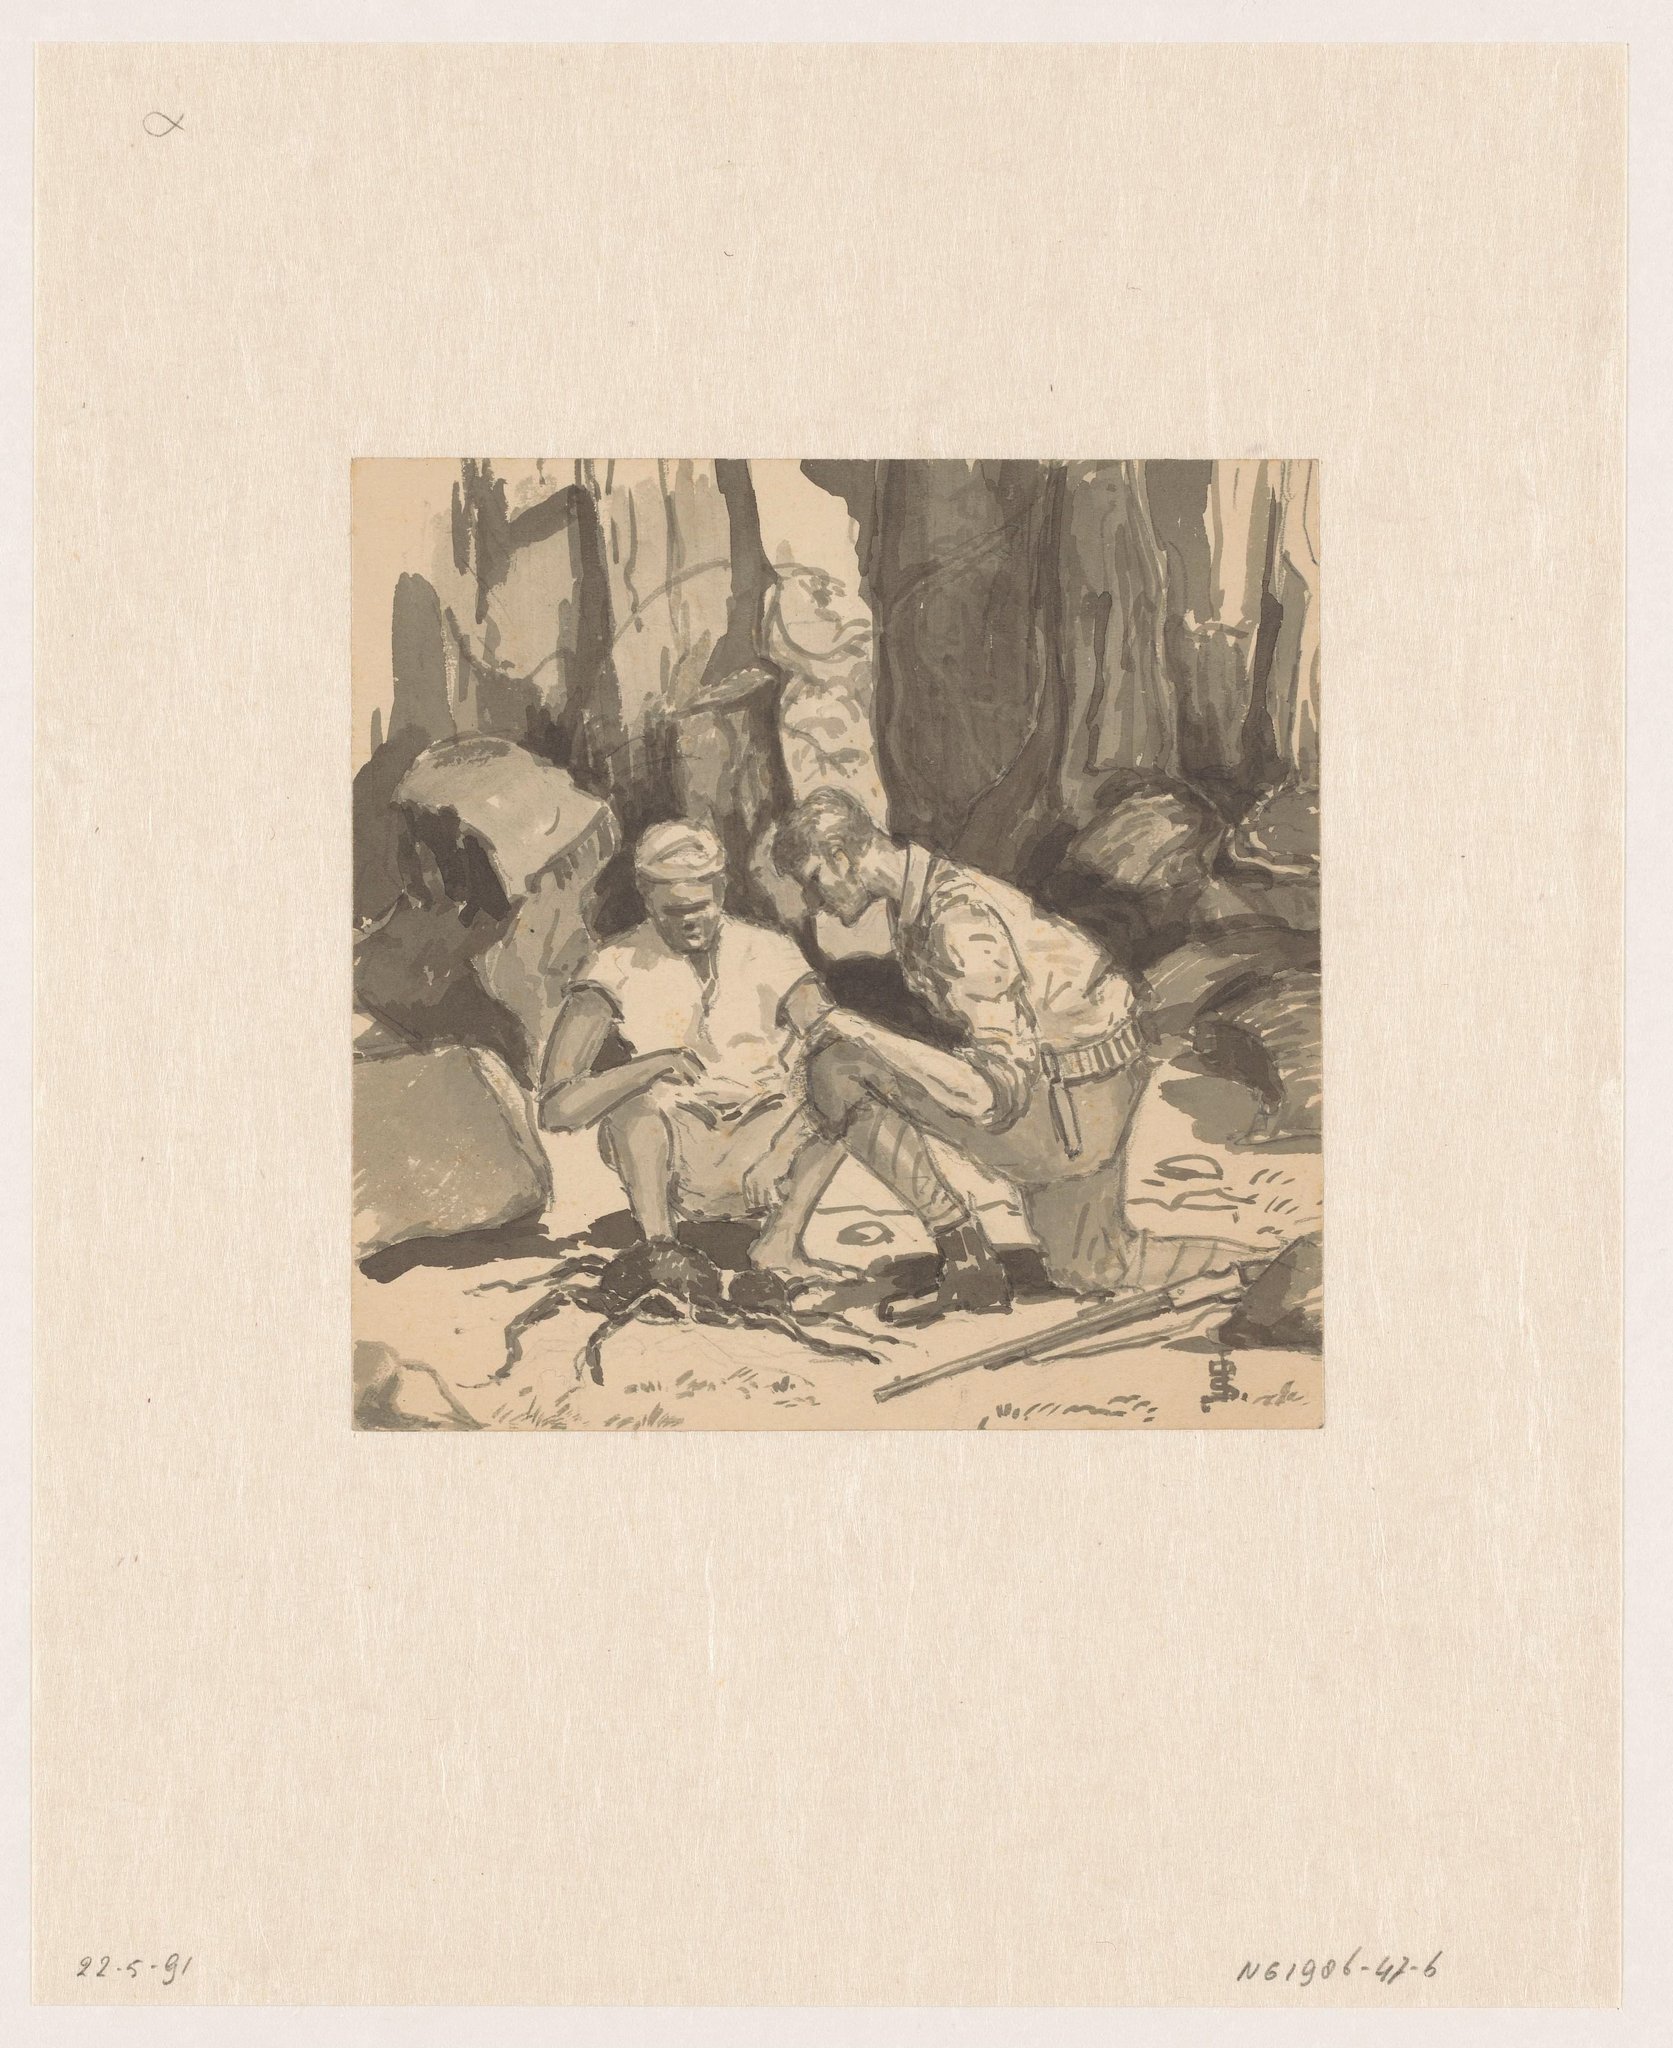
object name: drawing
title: Soldaten met spin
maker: johan gerard sinia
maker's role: draughtsman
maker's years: 1875-1948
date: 1900-1910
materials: paint, paper, pencil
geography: south celebes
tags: draughtsman, johan gerard sinia, military service, spiders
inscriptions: inscription: ‘...maar welk een spin!’, signature: ‘JGS’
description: J. G. Sinia was KNIL-officier, auteur en kunstenaar. Hij bezocht de buitenposten van Nederlands-Indië in de eerste jaren van de 20e eeuw. In april 1908 wordt Sinia overgeplaatst naar Zuidwest-Celebes. Hij wordt hier als militair en civiel gezaghebber aangesteld in het bebied Soppeng. Op 12 oktober 1909 keert hij terug naar Nederland.